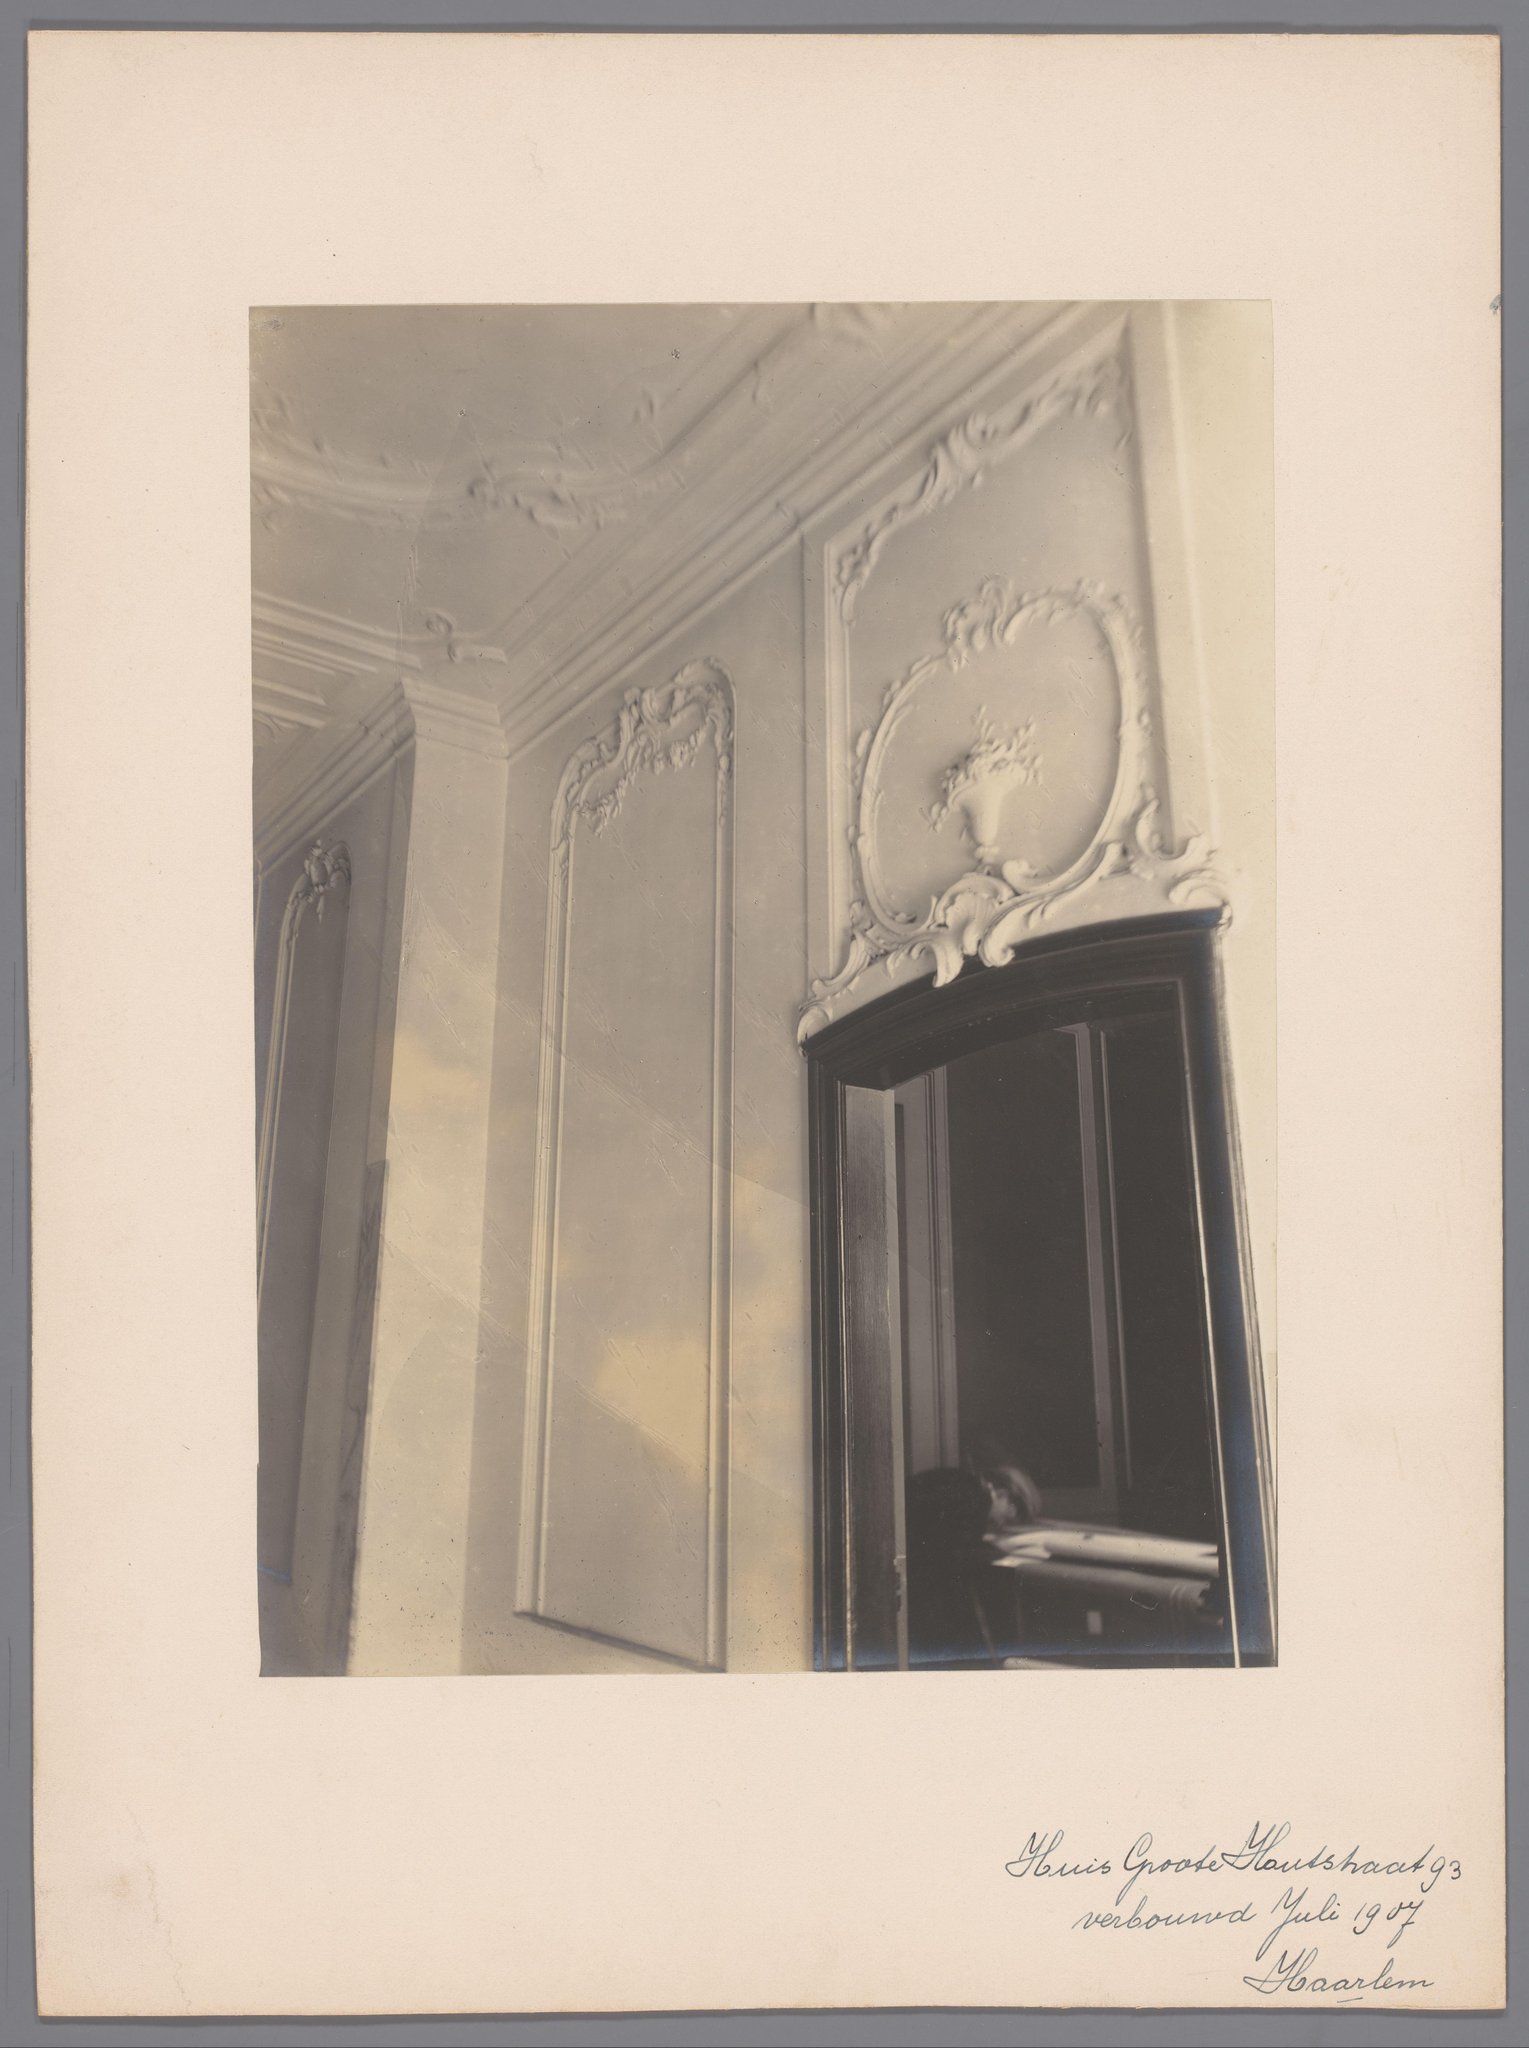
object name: photograph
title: Kamer in het pand op de Grote Houtstraat 39 te Haarlem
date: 1907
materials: cardboard, photographic support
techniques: gelatin silver print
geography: grote houtstraat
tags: urban housing, interior of the house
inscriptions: annotation: ‘Haarlem/ Huis groote Houtstraat 39/ verbouwd Juli 1907’, annotation: ‘Huis Groote Houtstraat 93/ verbouwd Juli 1907/ Haarlem’